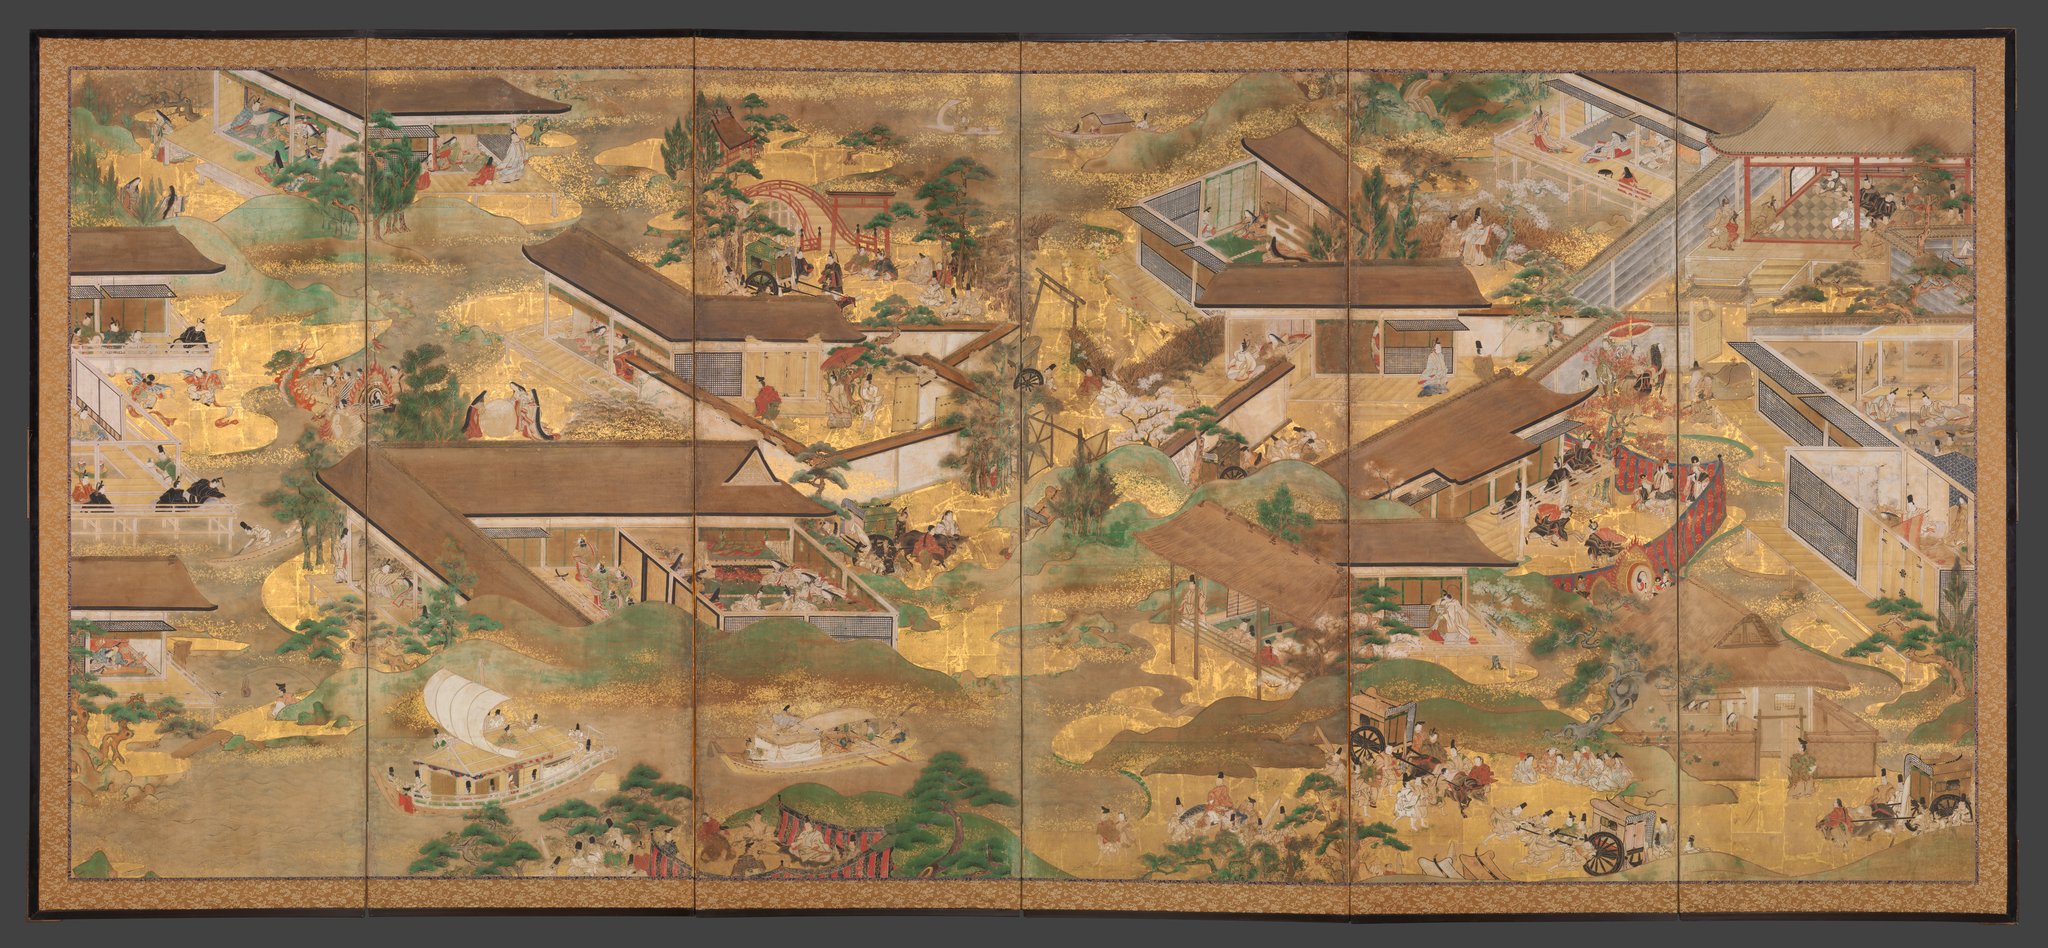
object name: screen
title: Fifty-Four Scenes from The Tale of Genji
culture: japanese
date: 1667-1700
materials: gold, gold leaf, ink, panel, paper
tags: interiors,men,women